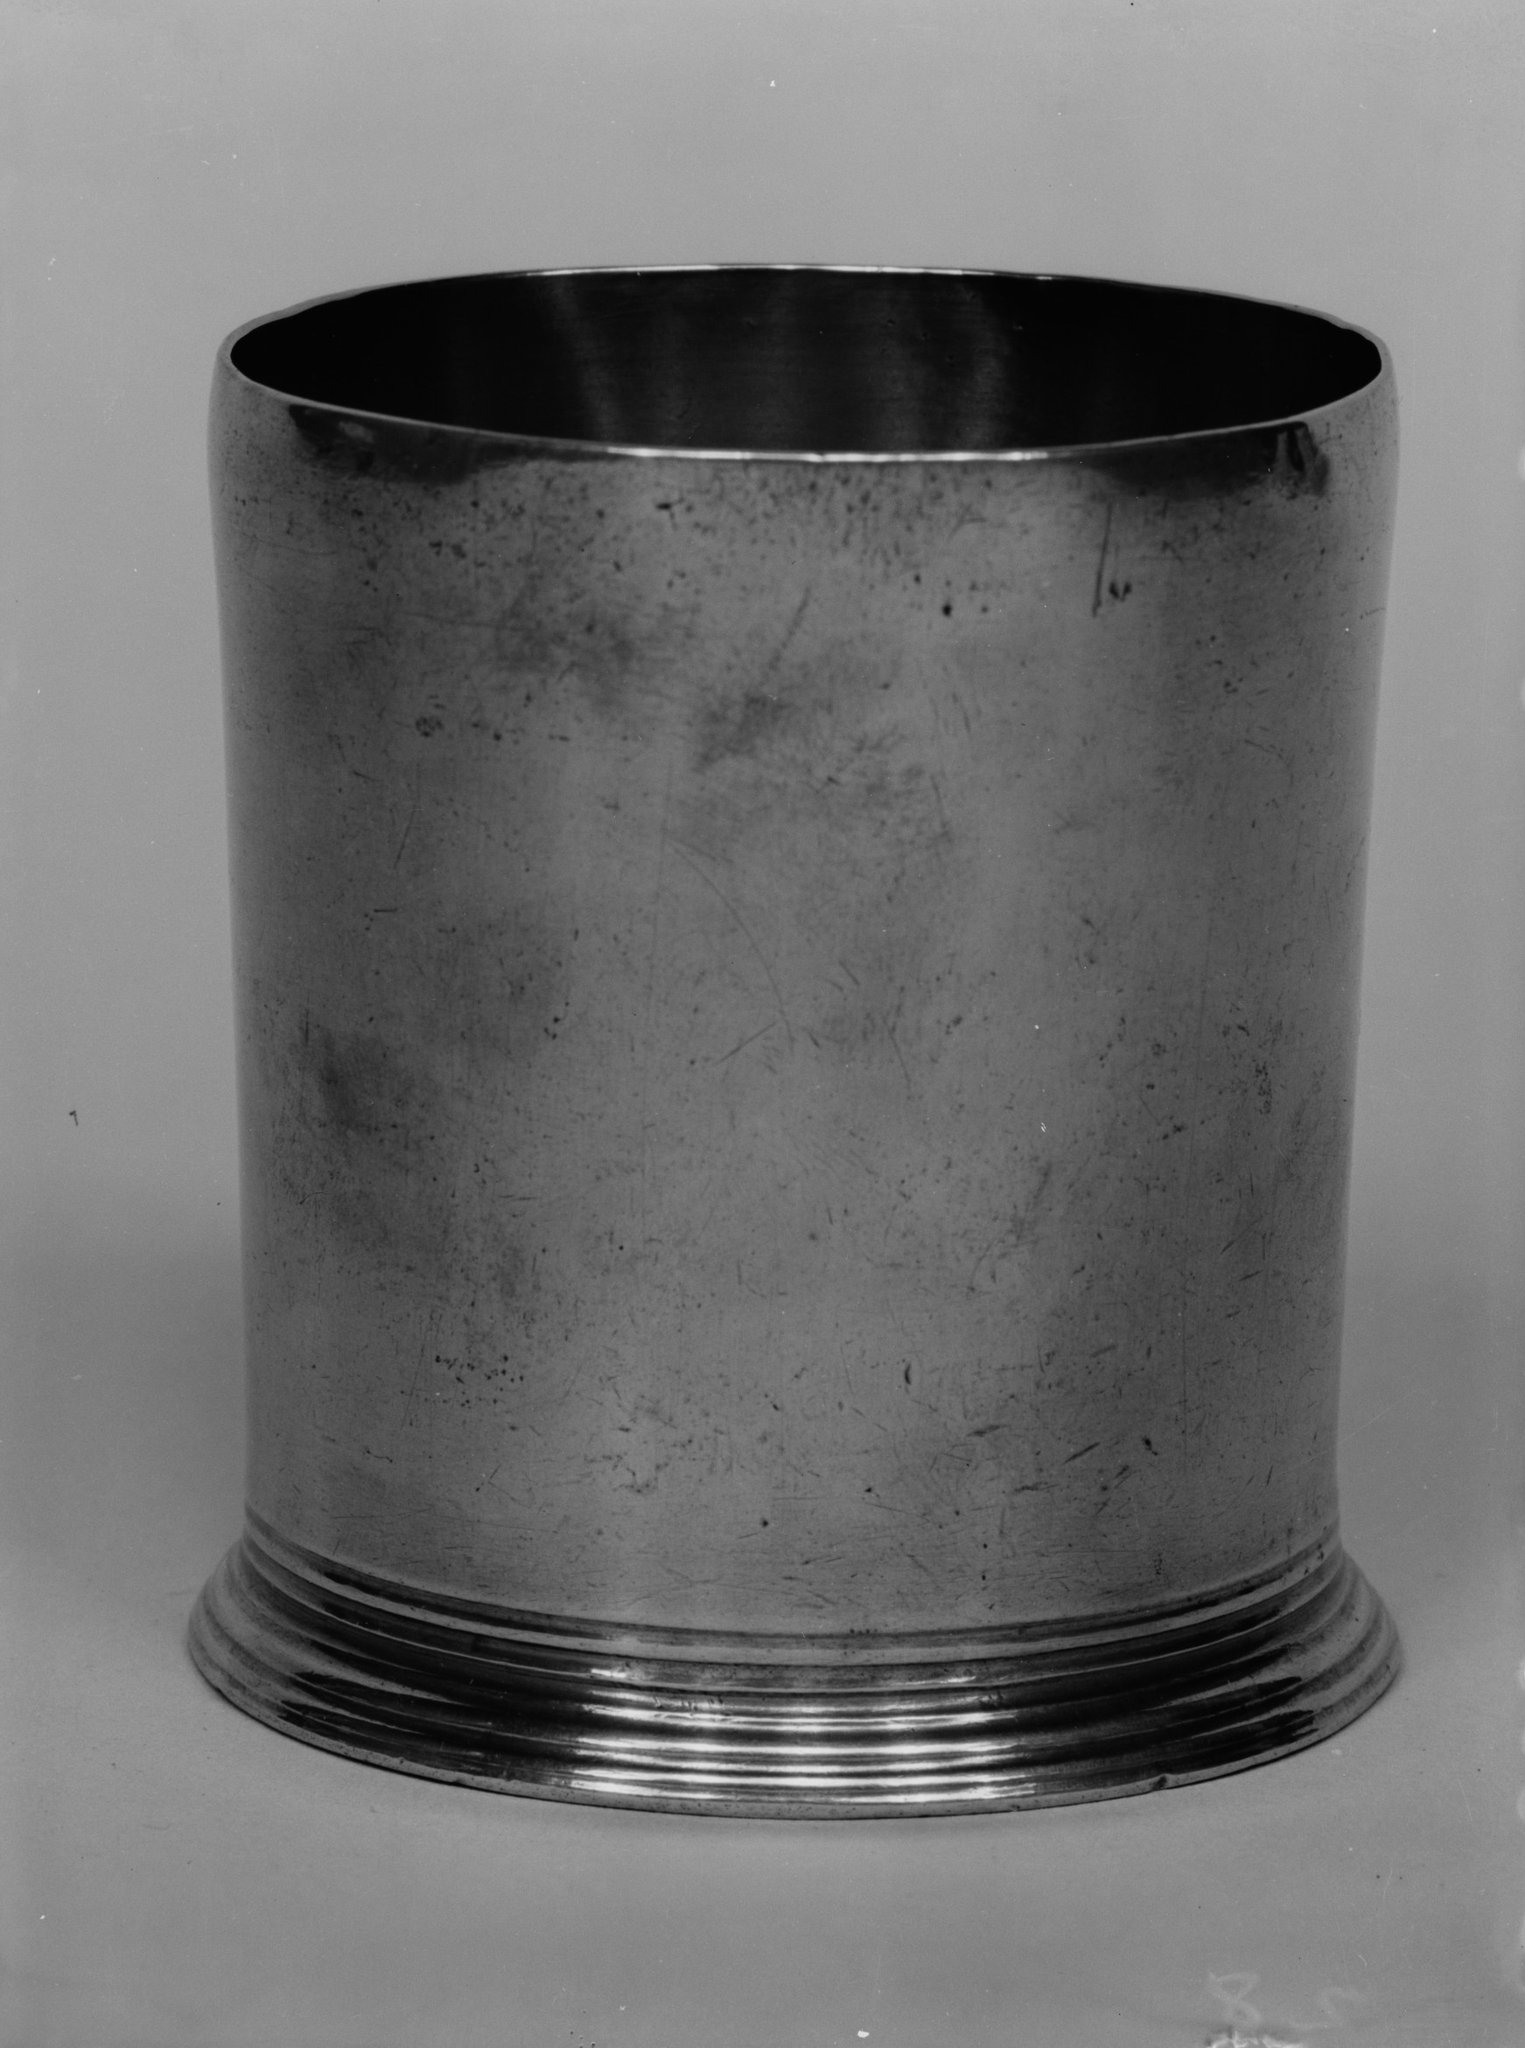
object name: beaker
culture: american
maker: samuel danforth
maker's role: maker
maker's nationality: american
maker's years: 1774-1816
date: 1795-1816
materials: pewter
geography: united states